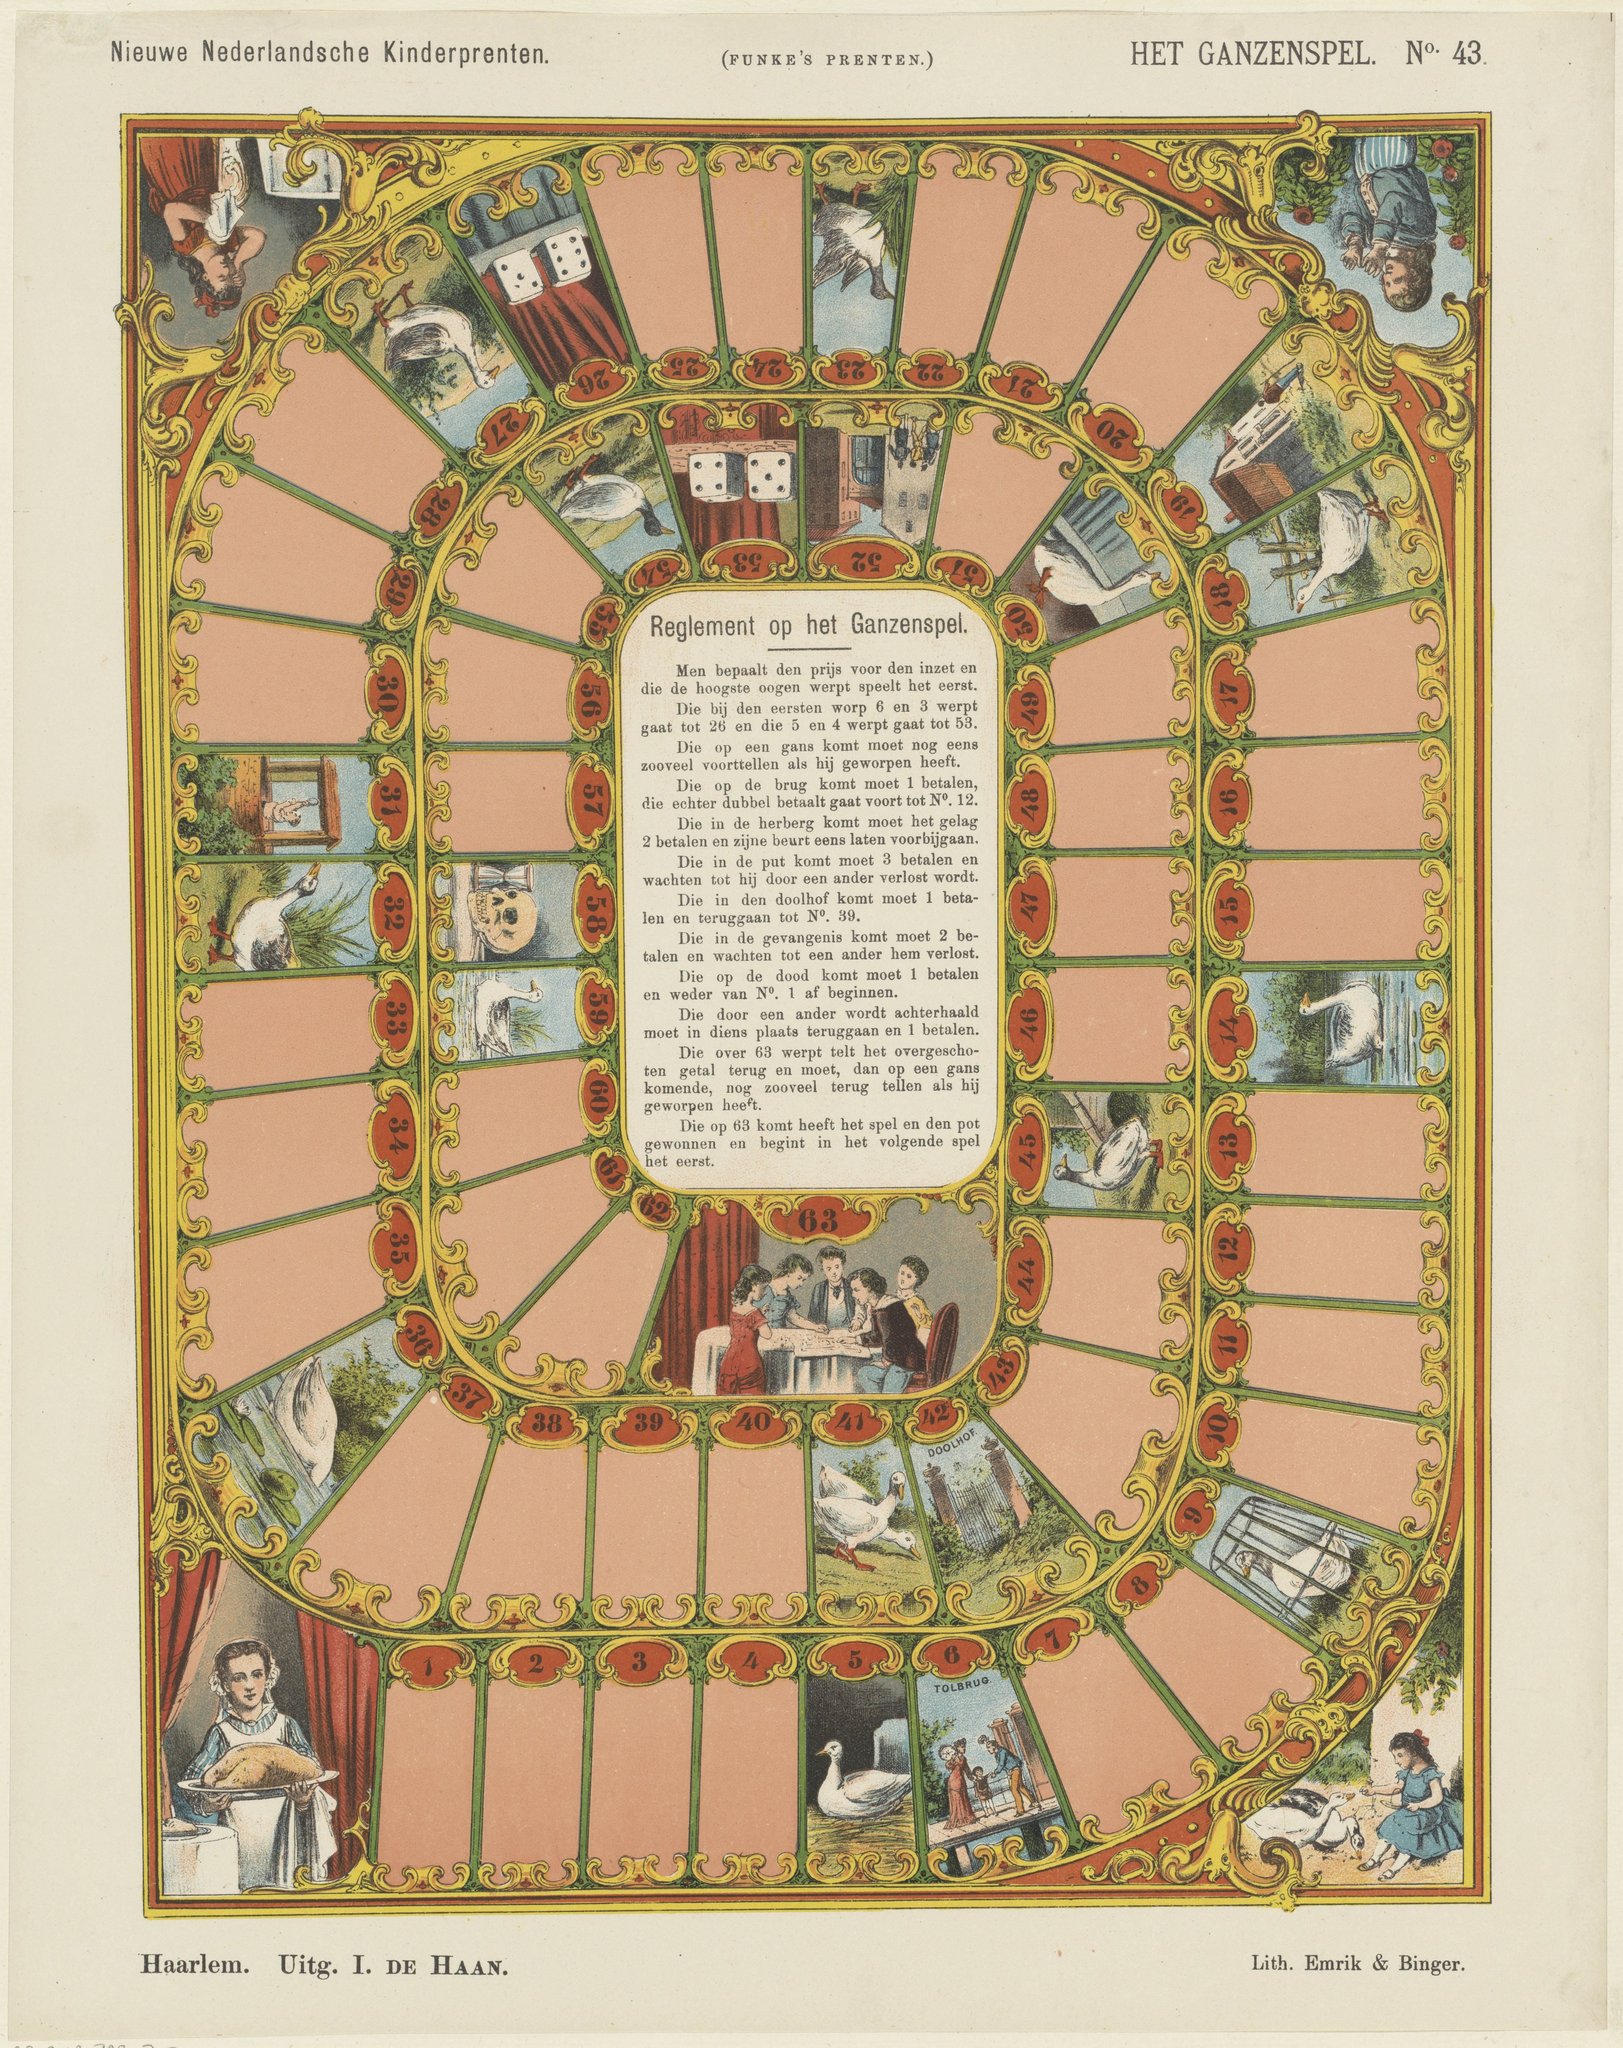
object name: gameboard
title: Funke's prenten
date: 1875-1903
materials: paper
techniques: lithograph, letterpress printing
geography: haarlem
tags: goose-game, child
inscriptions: collector's mark: Lugt 2760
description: Ganzenbordspel met een spiraal met vakjes genummerd van 1 tot en met 63. In de vier hoeken van het bord voorstellingen van kinderen. In enkele vakjes voorstellingen van ganzen. Op het middenveld de spelregels in boekdruk. Genummerd rechtsboven: No. 43.